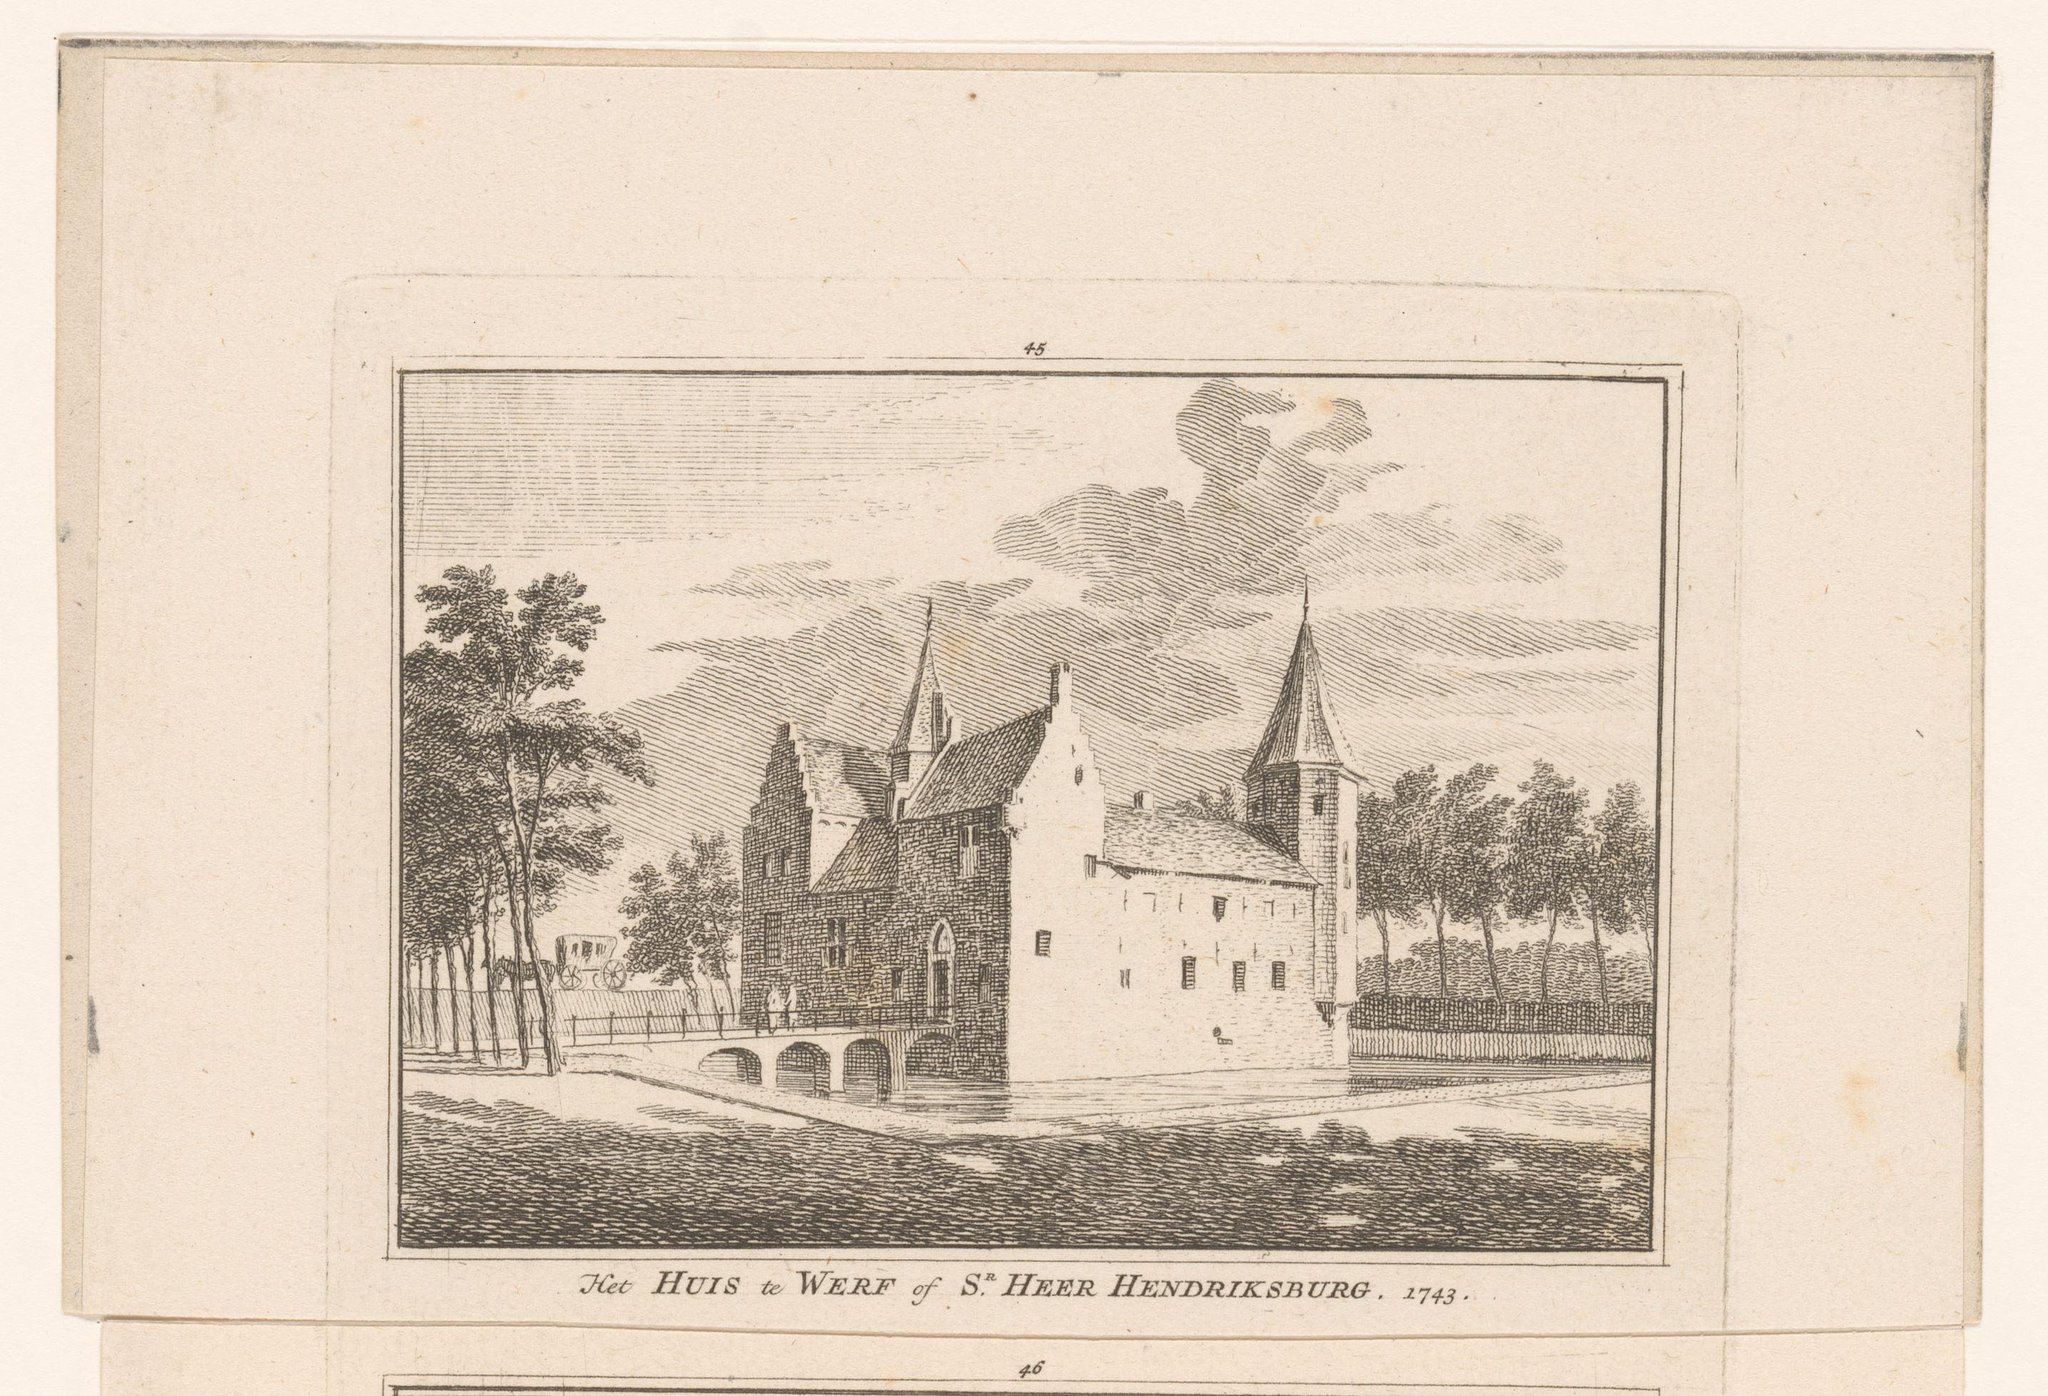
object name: print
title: Gezicht op het kasteel 's-Heer Hendriksburg, 1743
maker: hendrik spilman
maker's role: draughtsman, painter, print maker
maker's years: 1721-1784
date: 1754-1792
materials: paper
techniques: etching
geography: haarlem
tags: castle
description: Prent ook gebruikt in: Het verheerlykt Nederland of kabinet van hedendaagsche gezigten van steden, dorpen (…). 9 delen. Amsterdam: Isaak Tirion en weduwe Isaak Tirion, 1745-1774, dl. 5 (1754), ill. 45. Of in: Nederlandsche tafereelen; of eene keurige verzameling van negen honderd fraaije gezigten van steden, dorpen, sloten, oudheden [….]. 9 delen. Amsterdam: Jan de Groot, 1792, dl. 5, ill. 45.